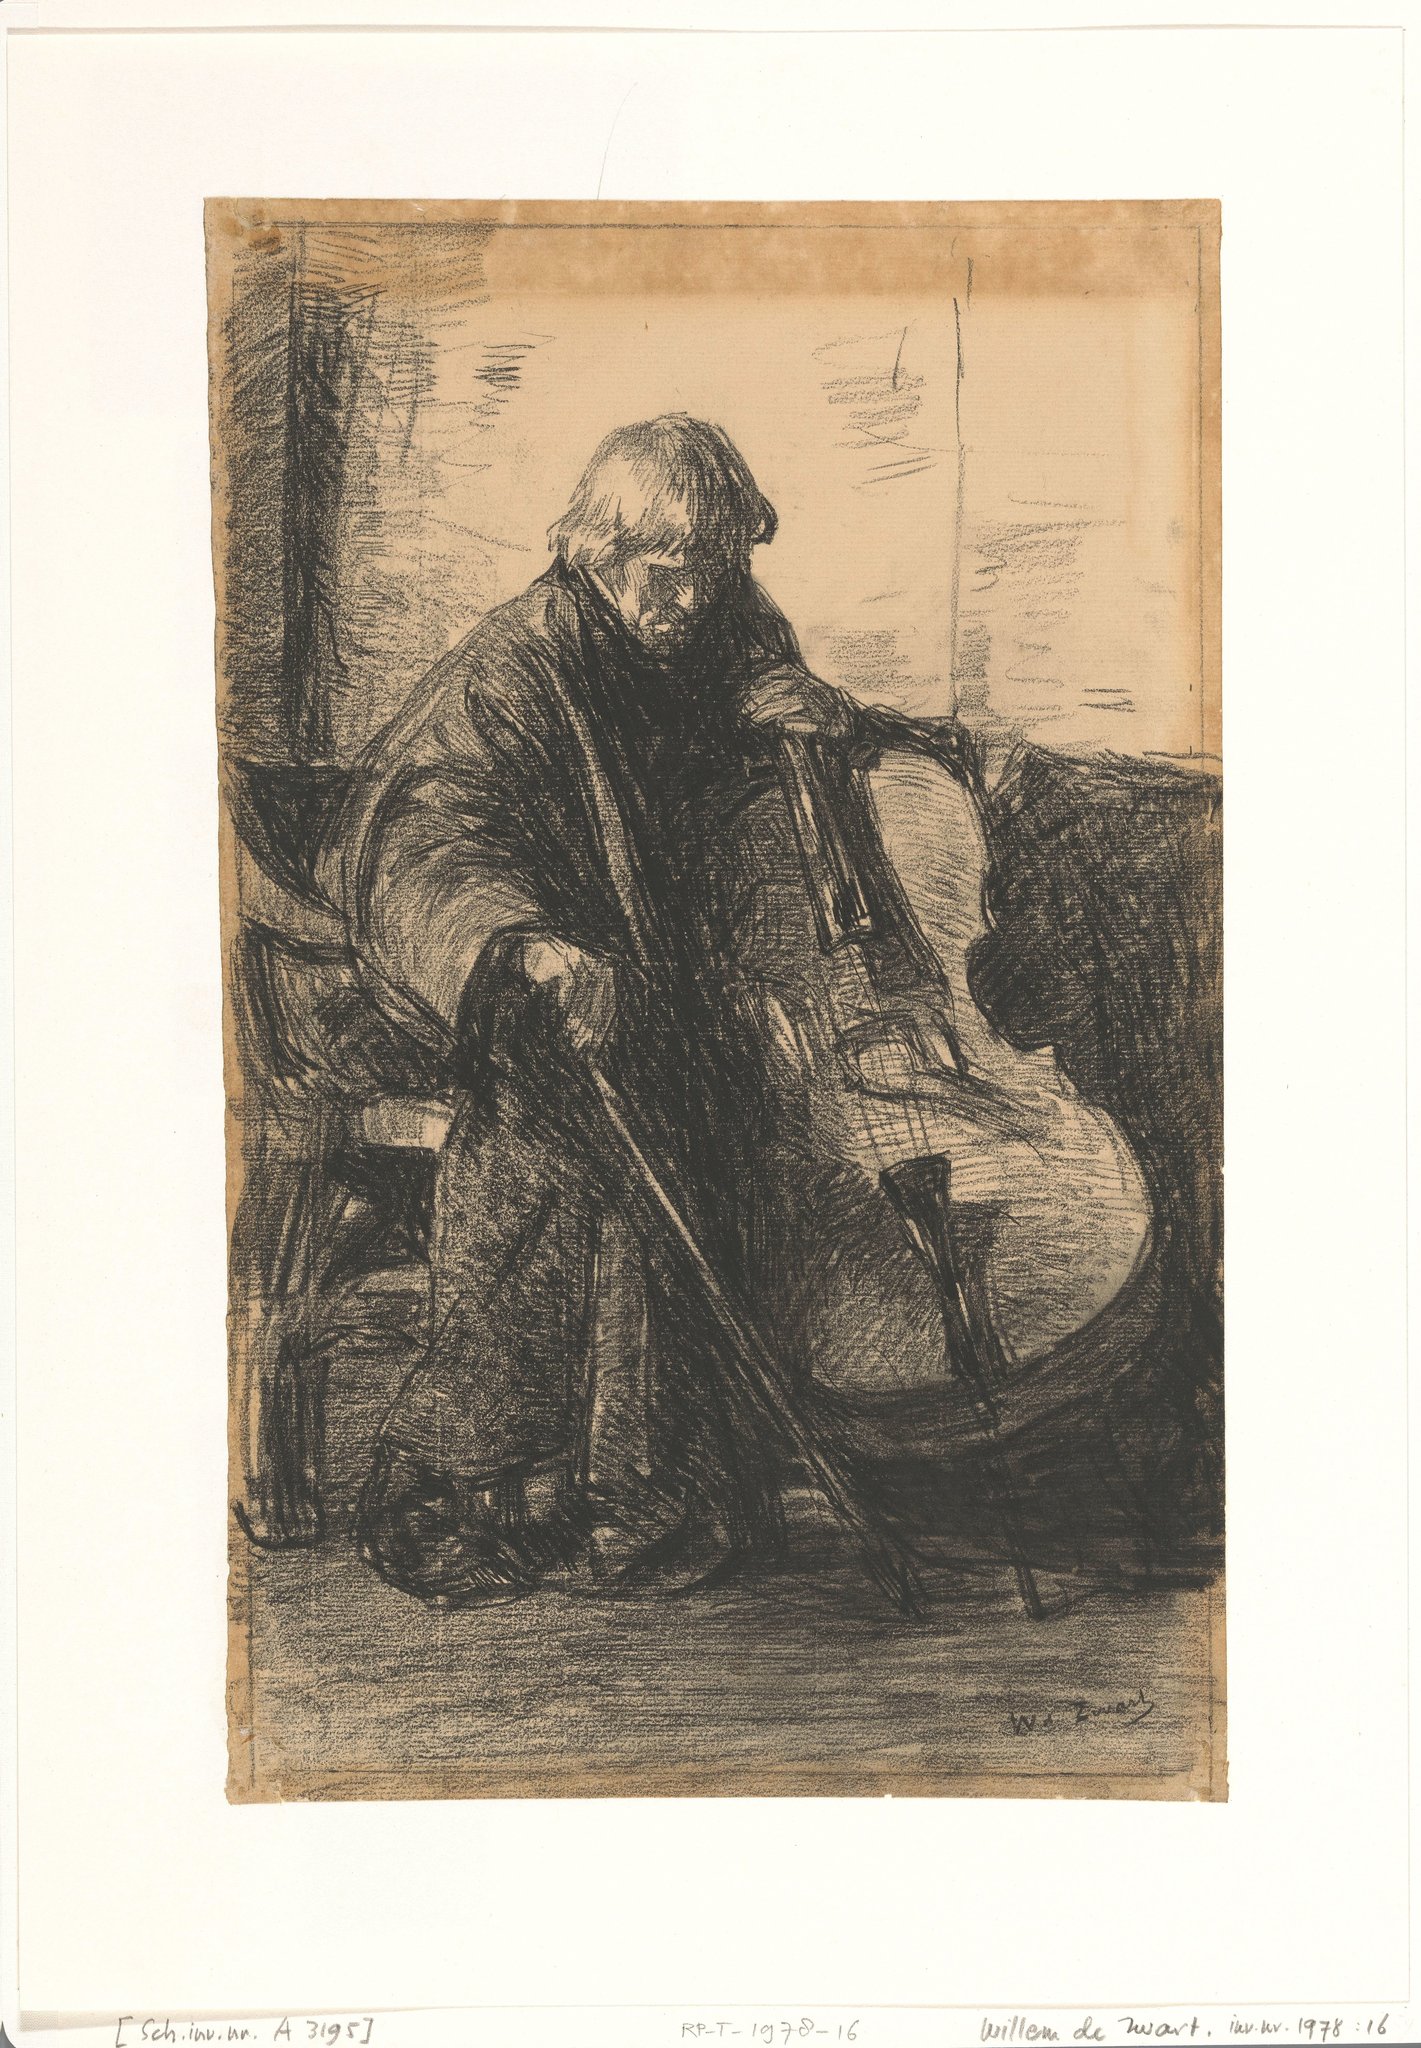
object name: drawing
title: Cellist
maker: willem de zwart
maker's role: draughtsman, painter, print maker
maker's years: 1862-1931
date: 1872-1931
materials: chalk, paper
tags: musician at work, other string instruments played with bow (cello)